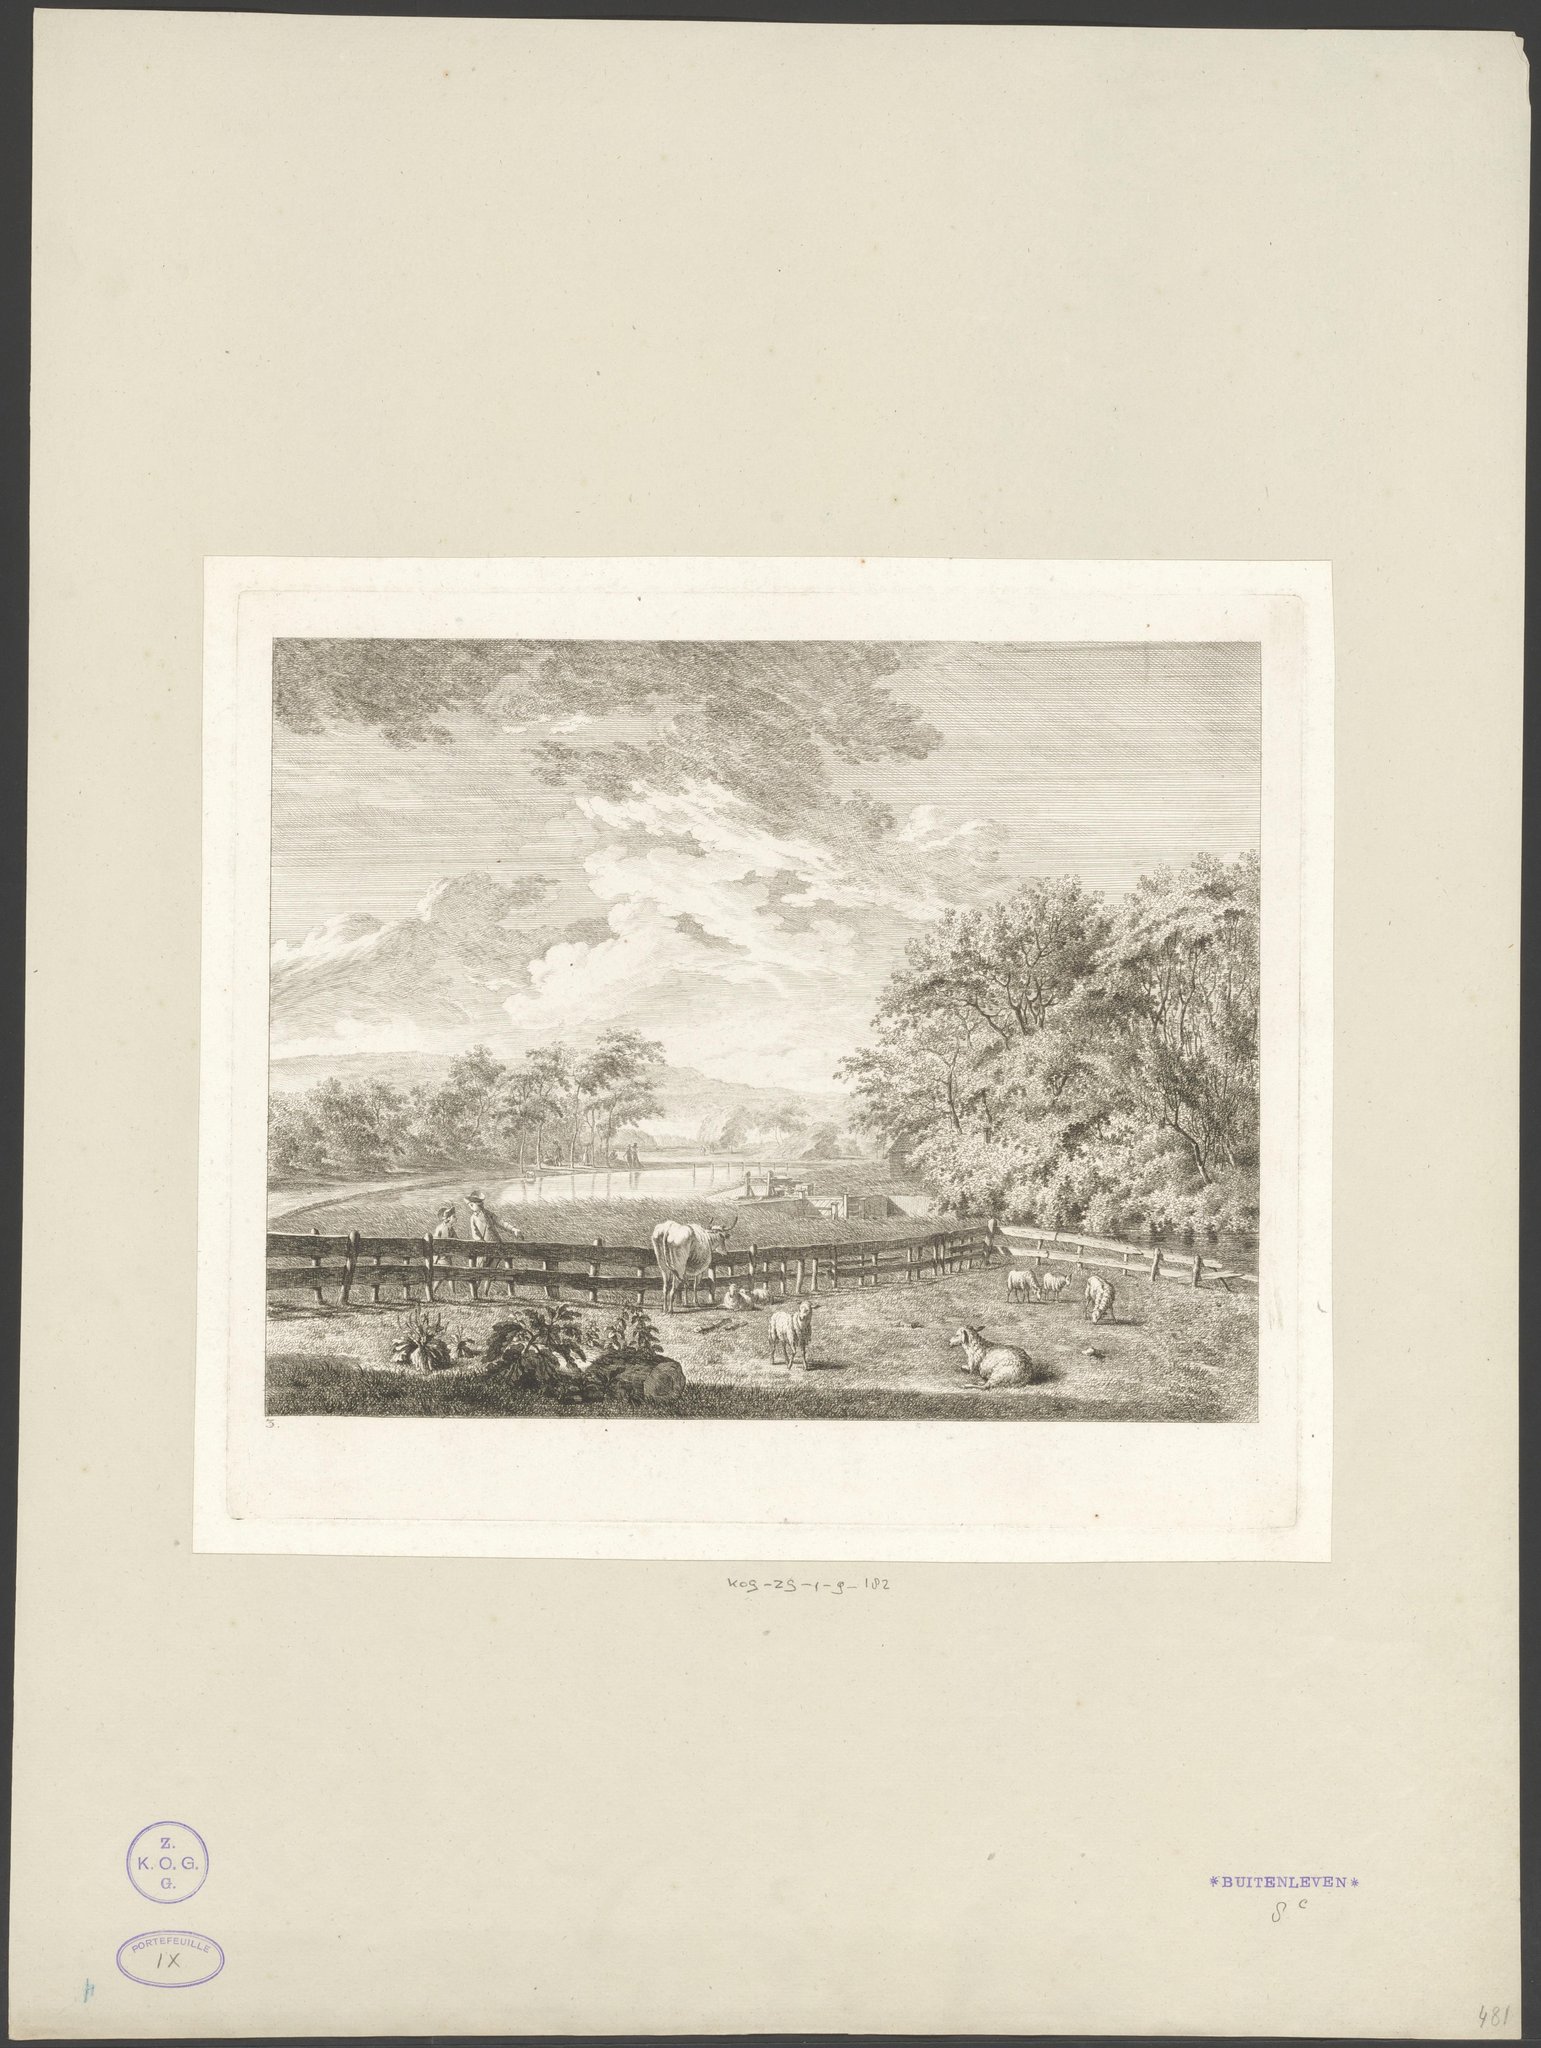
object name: print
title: Weiland met schapen en een koe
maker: Anonymous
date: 1750-1849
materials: paper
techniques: etching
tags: cattle, meadow, pasture, haarlem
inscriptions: collector's mark: Lugt 1641, stamp, stamp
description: Twee mannen staan aan het hek van een weiland met schapen en een koe. Linksonder: 3. Onderwerpsrubrieken binnen de Atlas Zeden en Gewoonten: Handel, nijverheid en verkeer, Buitenleven.